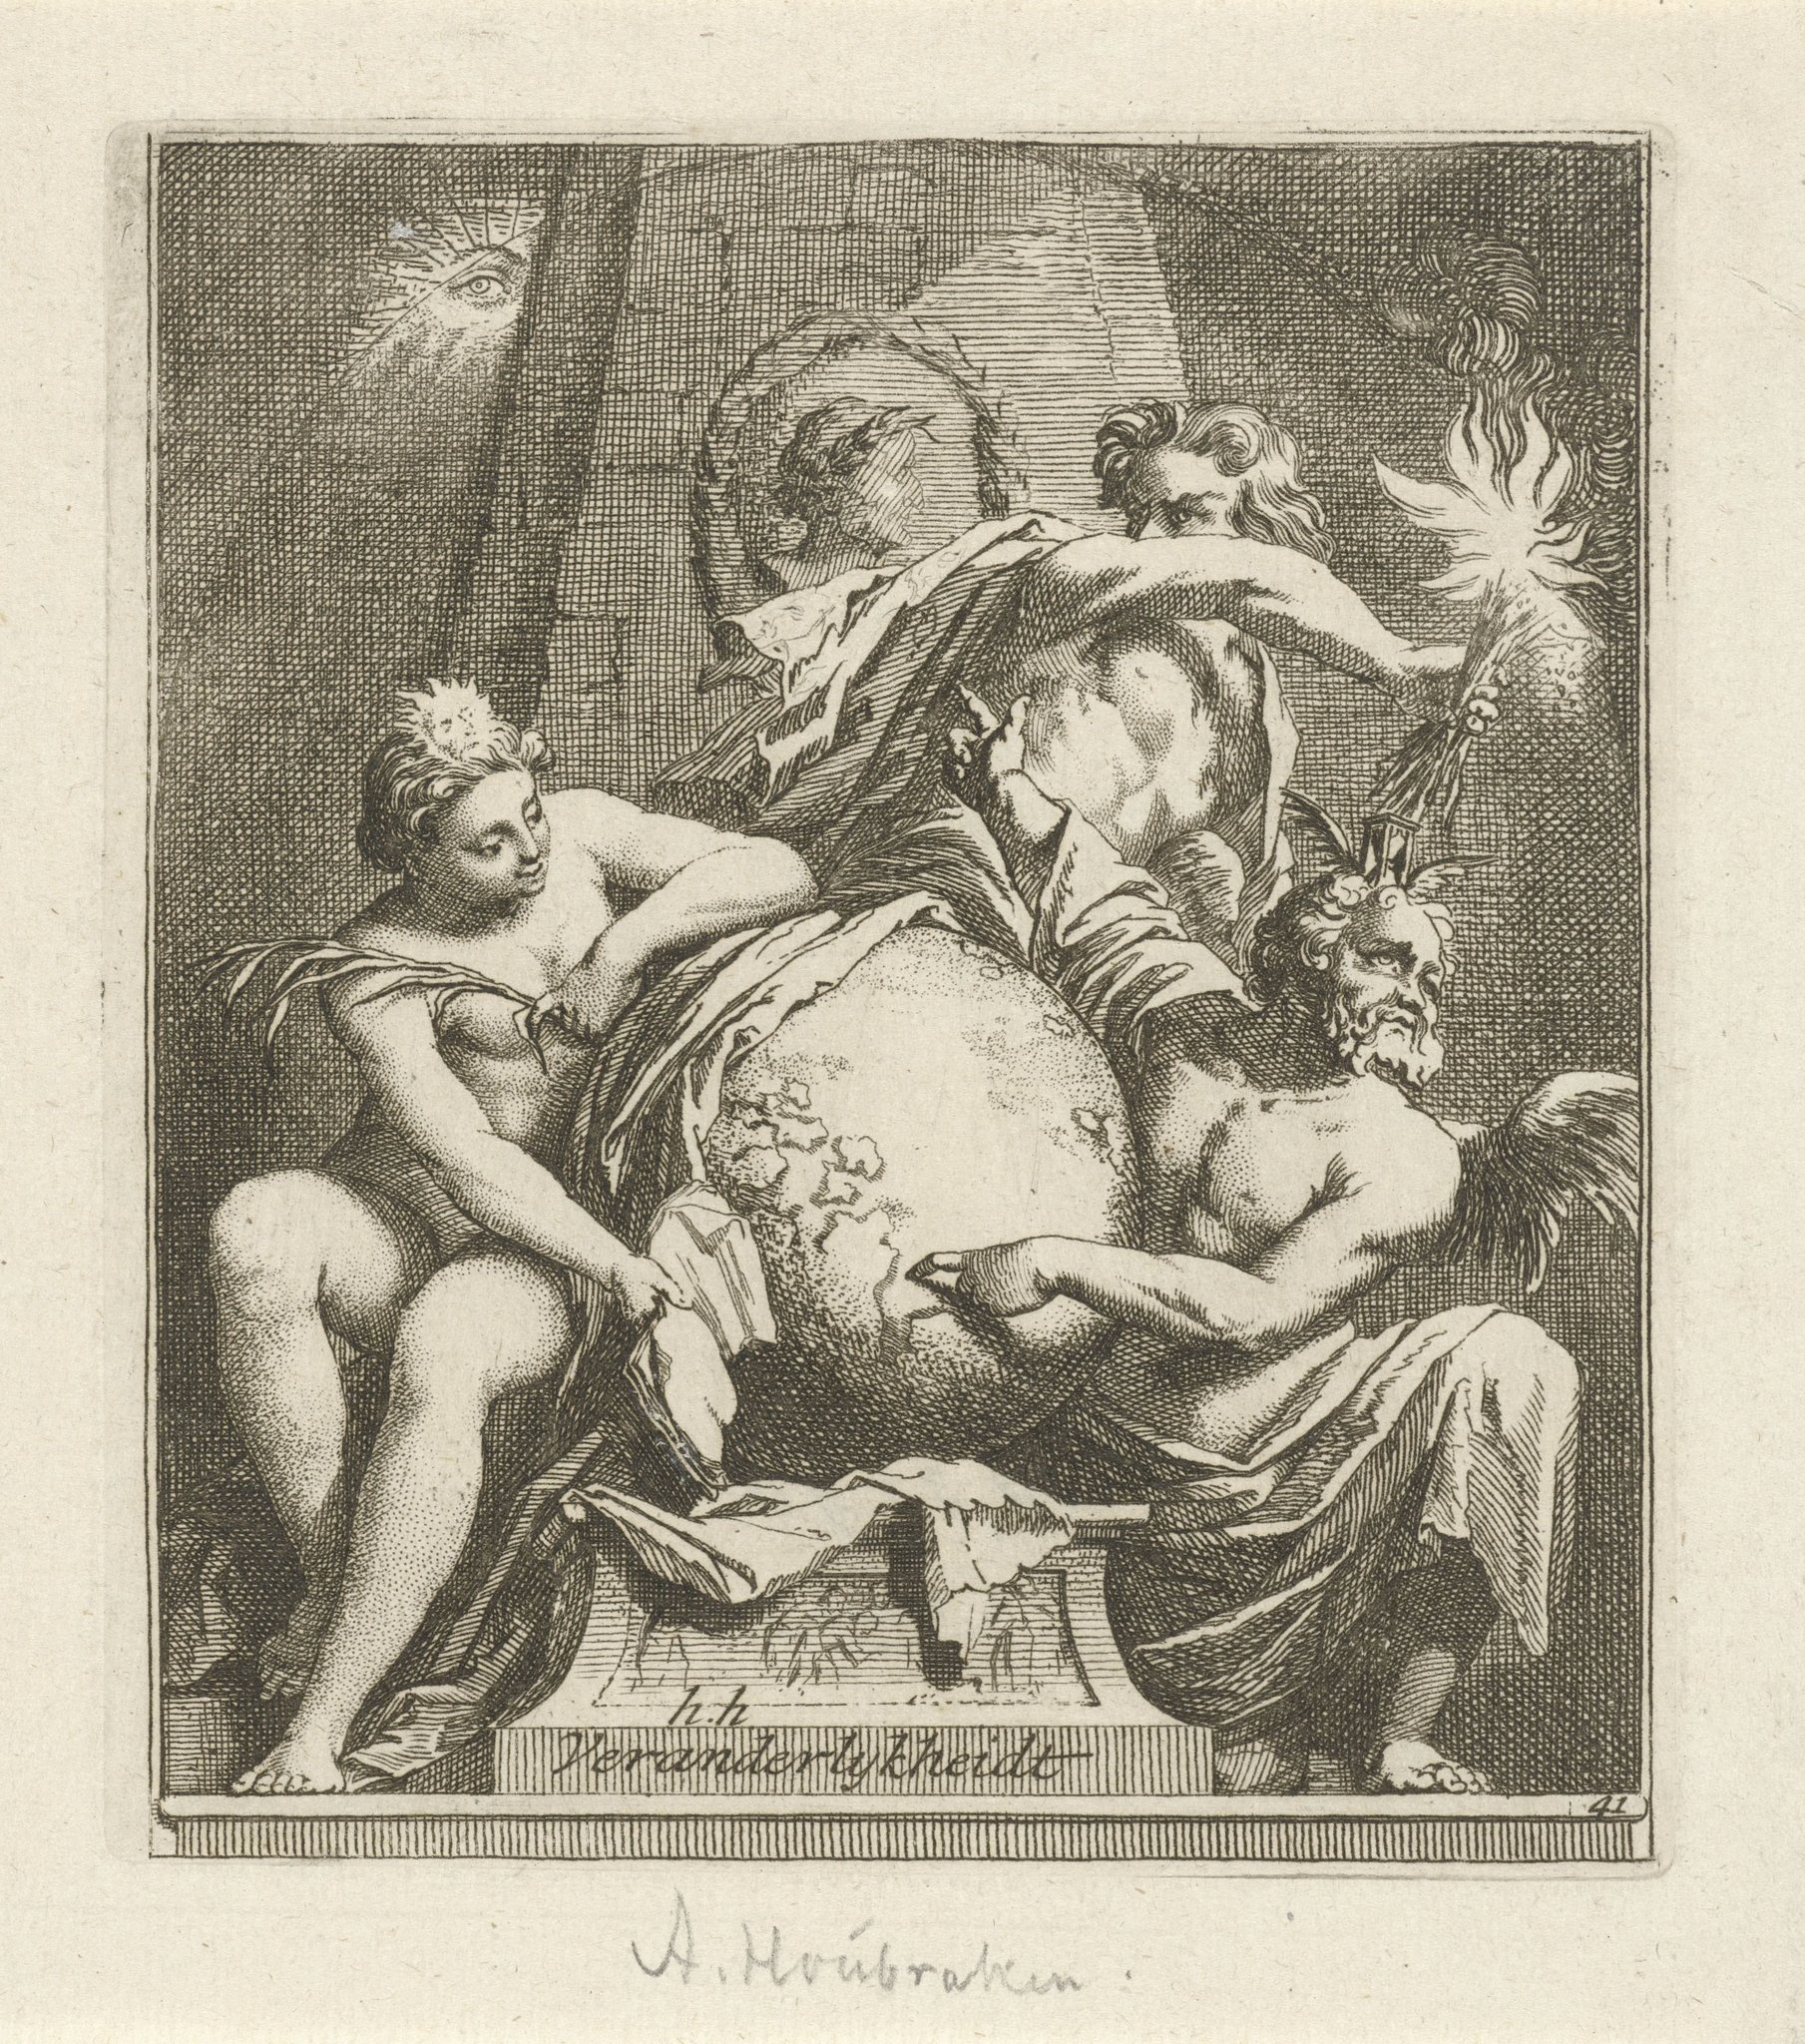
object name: print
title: Veranderlijkheidt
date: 1710-1719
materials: paper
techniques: engraving, etching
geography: amsterdam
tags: the all-seeing eye, triangle with eye ~ symbol of god the father, globe, father time, man with wings and scythe, change (+ allegorical scene, i.e. two or more personifications involved in an action), truth; 'verità' (ripa) (+ nude)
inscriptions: collector's mark: Lugt 2228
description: Allegorische voorstelling met een wereldbol, op een piëdestal met een bas-reliëf, die wordt geflankeerd door Vader Tijd (rechts), met op zijn hoofd een zandloper en vleugels op zijn rug en de gepersonifieerde Waarheid (links), met op haar hoofd een zon. Vader Tijd wijst met een hand op de wereldbol met met zijn andere op een Alziend oog linksboven in de achtergrond. Achter de wereldbol een derde figuur, de personificatie van de leugen, die zich afwendt met een brandende bos stro in zijn hand. Prent uit een serie van 41 zinnebeelden.